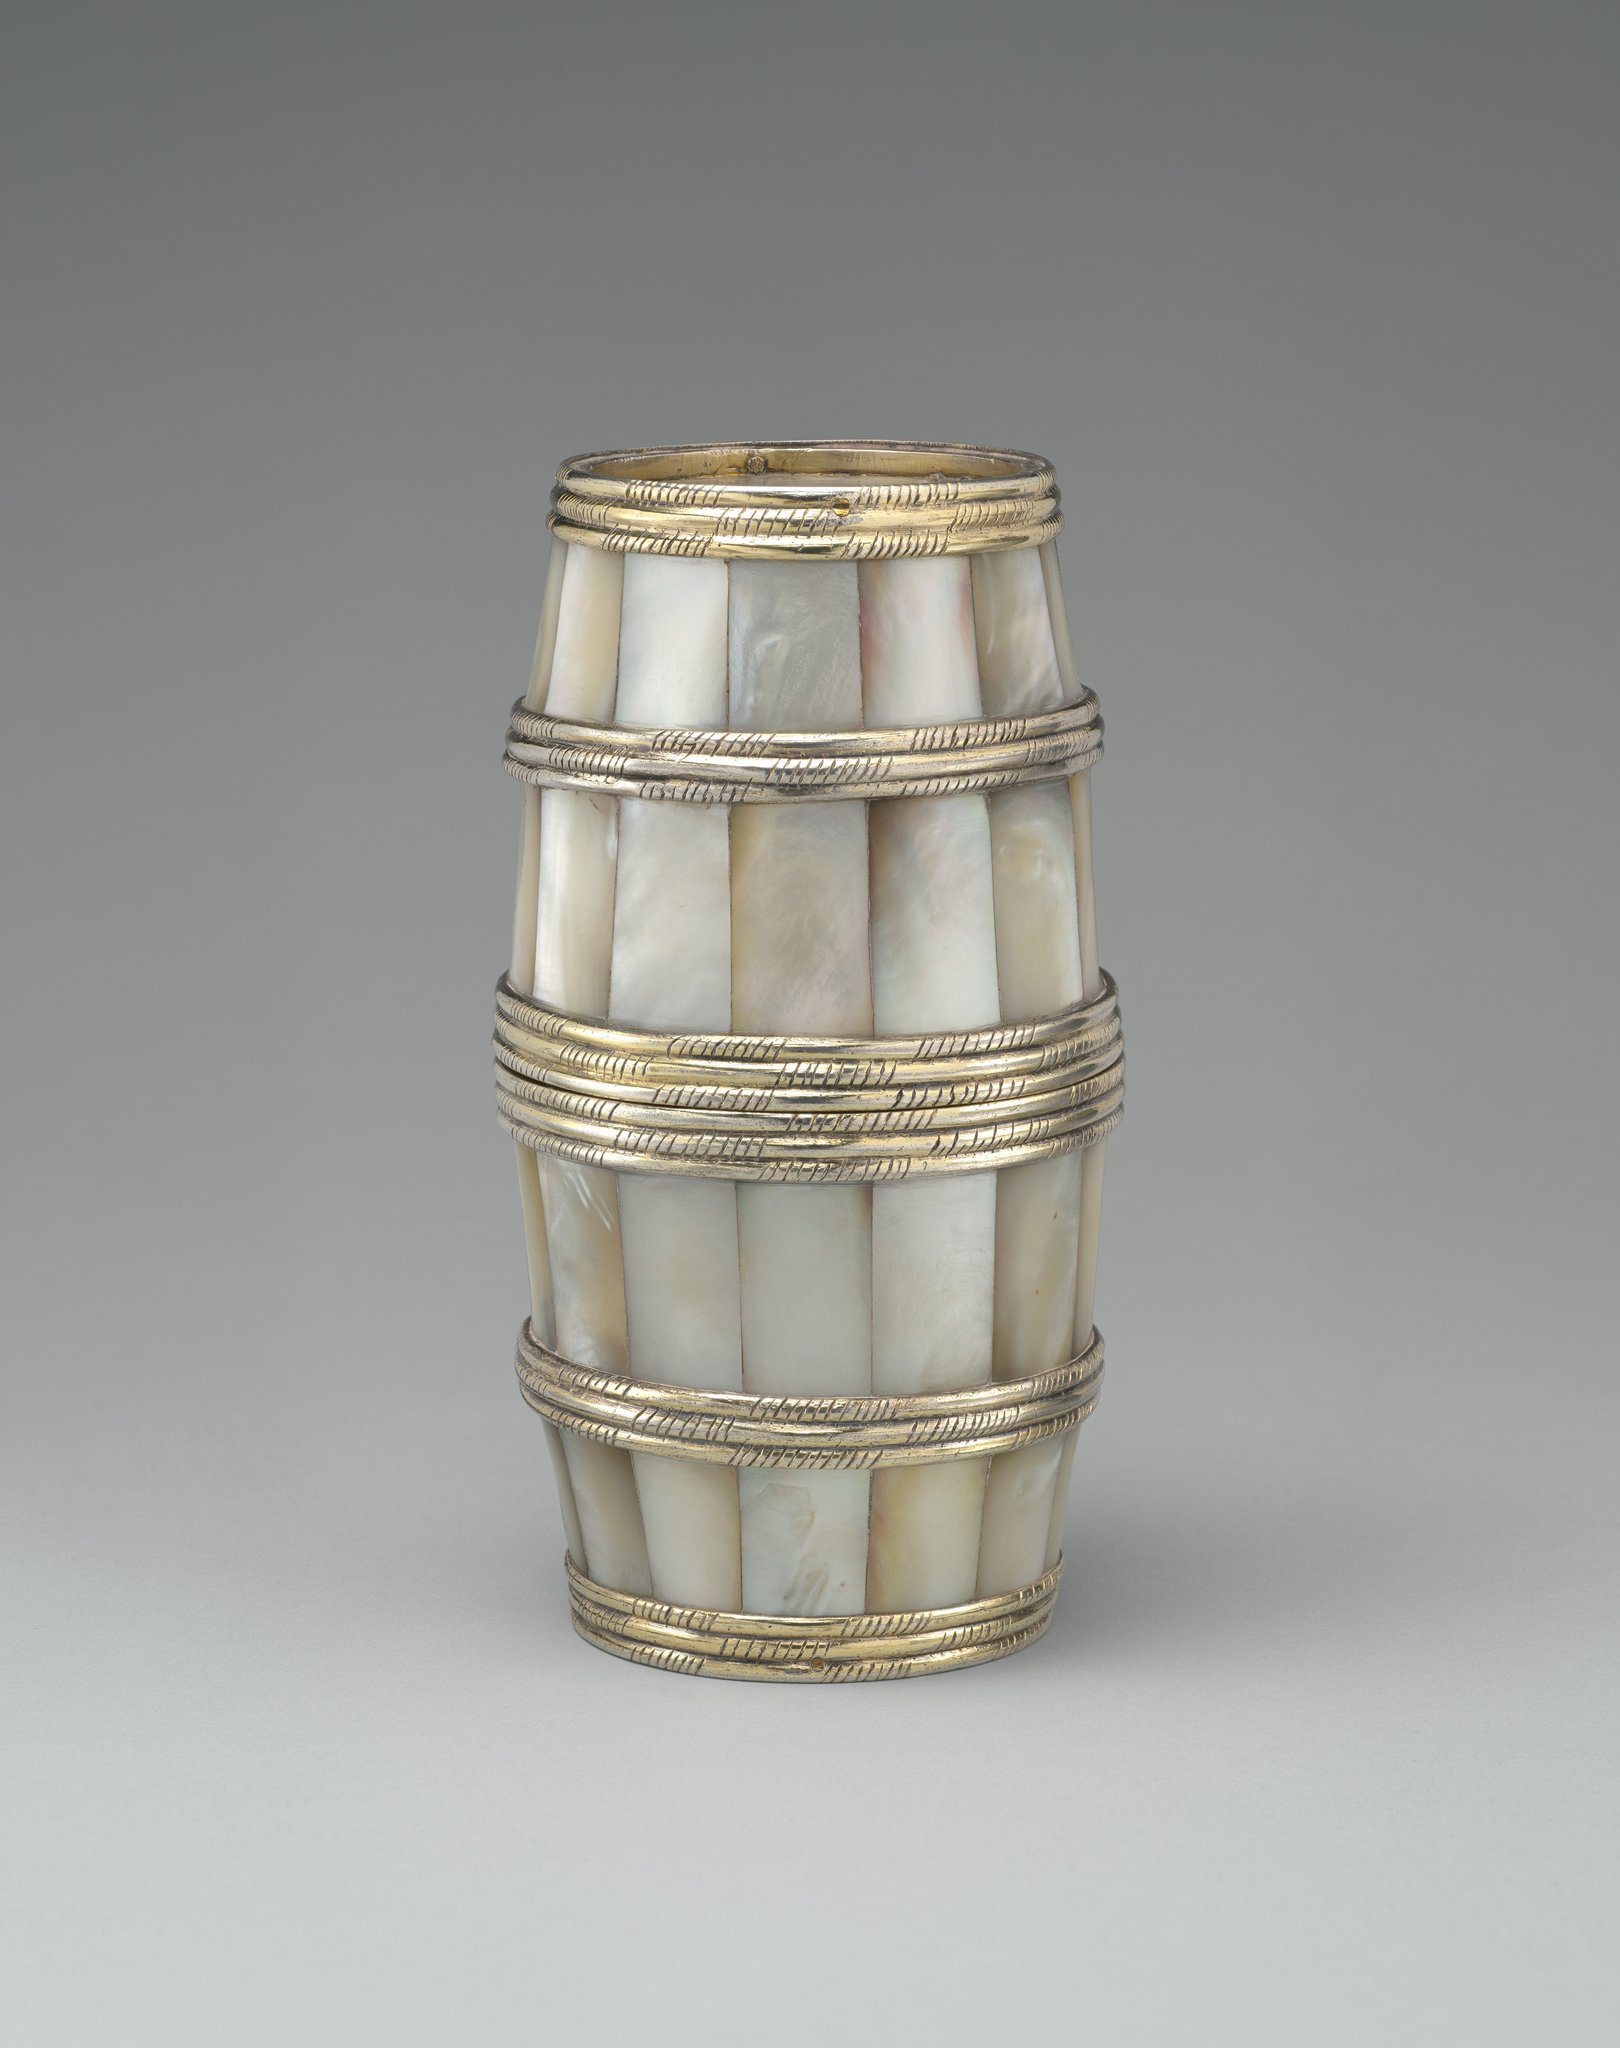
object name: double beaker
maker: georg rühl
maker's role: maker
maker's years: 1598-1625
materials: gilt silver, mother of pearl